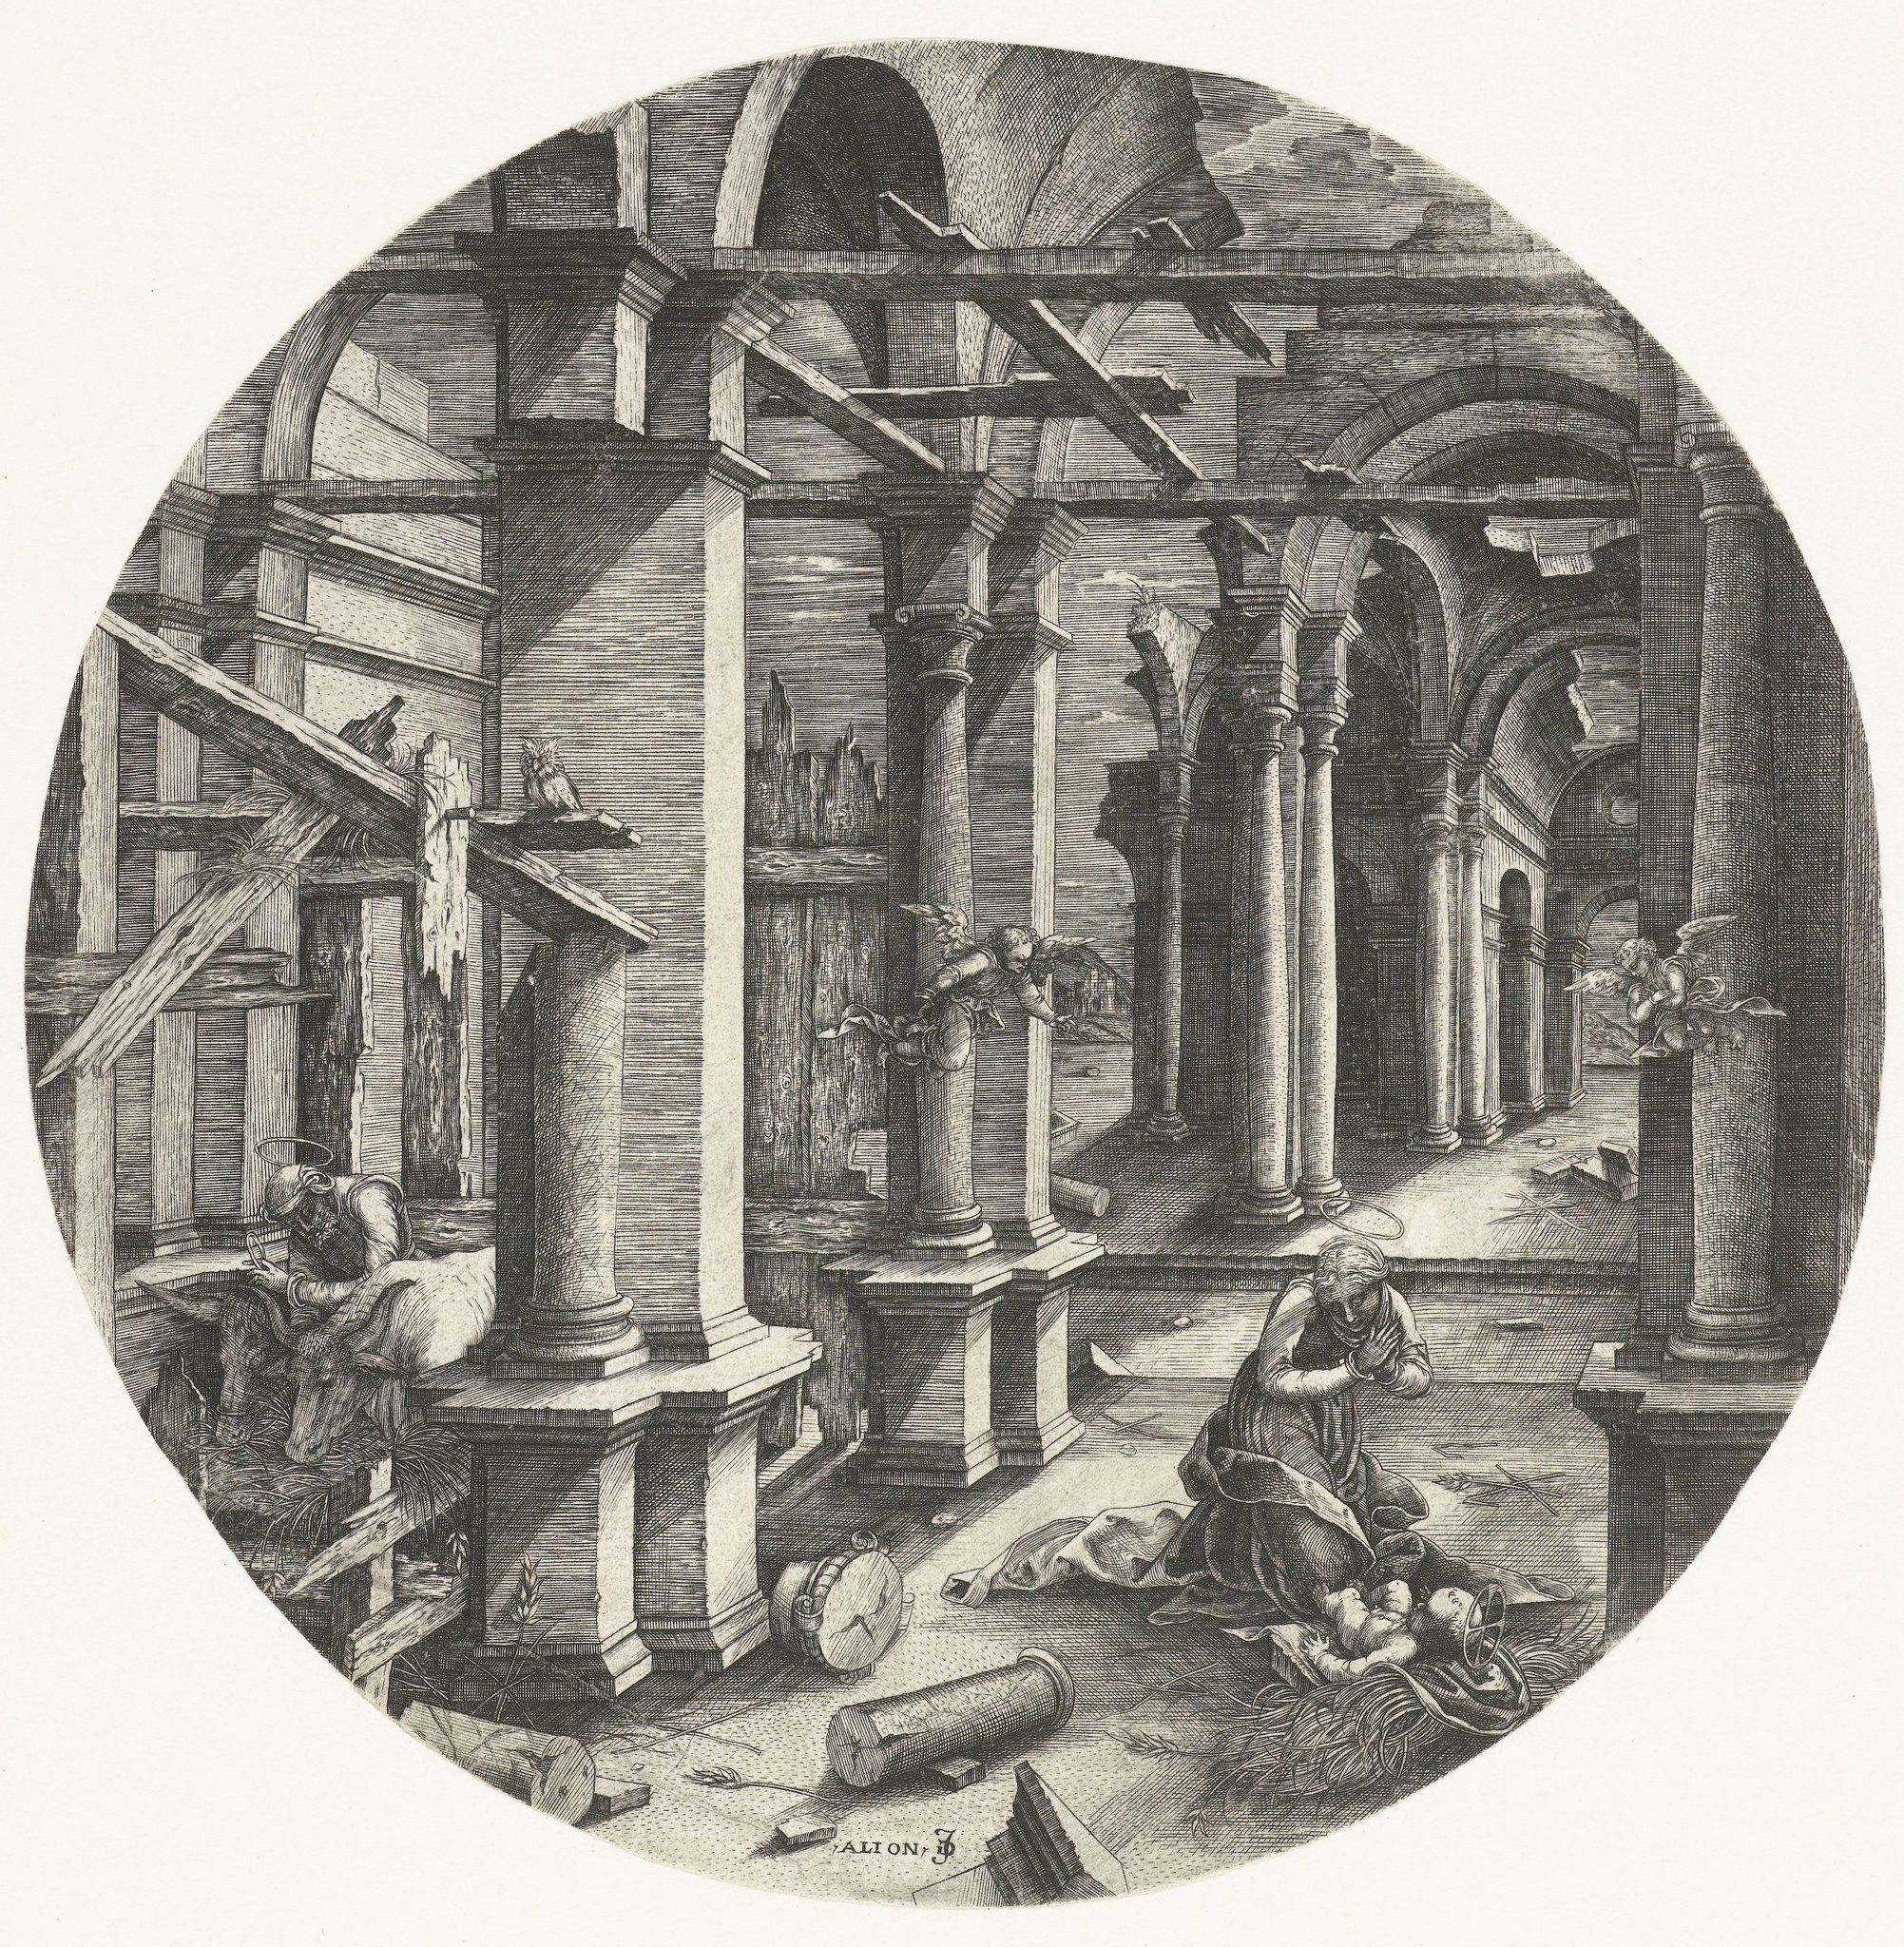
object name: print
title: De Heilige Familie in Bethlehem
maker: jean de gourmont (i)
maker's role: goldsmith, painter, print maker, publisher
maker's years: 1483-1557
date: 1498-1551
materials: paper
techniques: engraving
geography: lyon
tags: mary, joseph and the new-born christ (nativity)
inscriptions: collector's mark: Lugt 2760, collector's mark: Lugt 2228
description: In een ruïne zit Maria geknield bij het Chistuskind. Jozef verzorgt de ezel en de os.